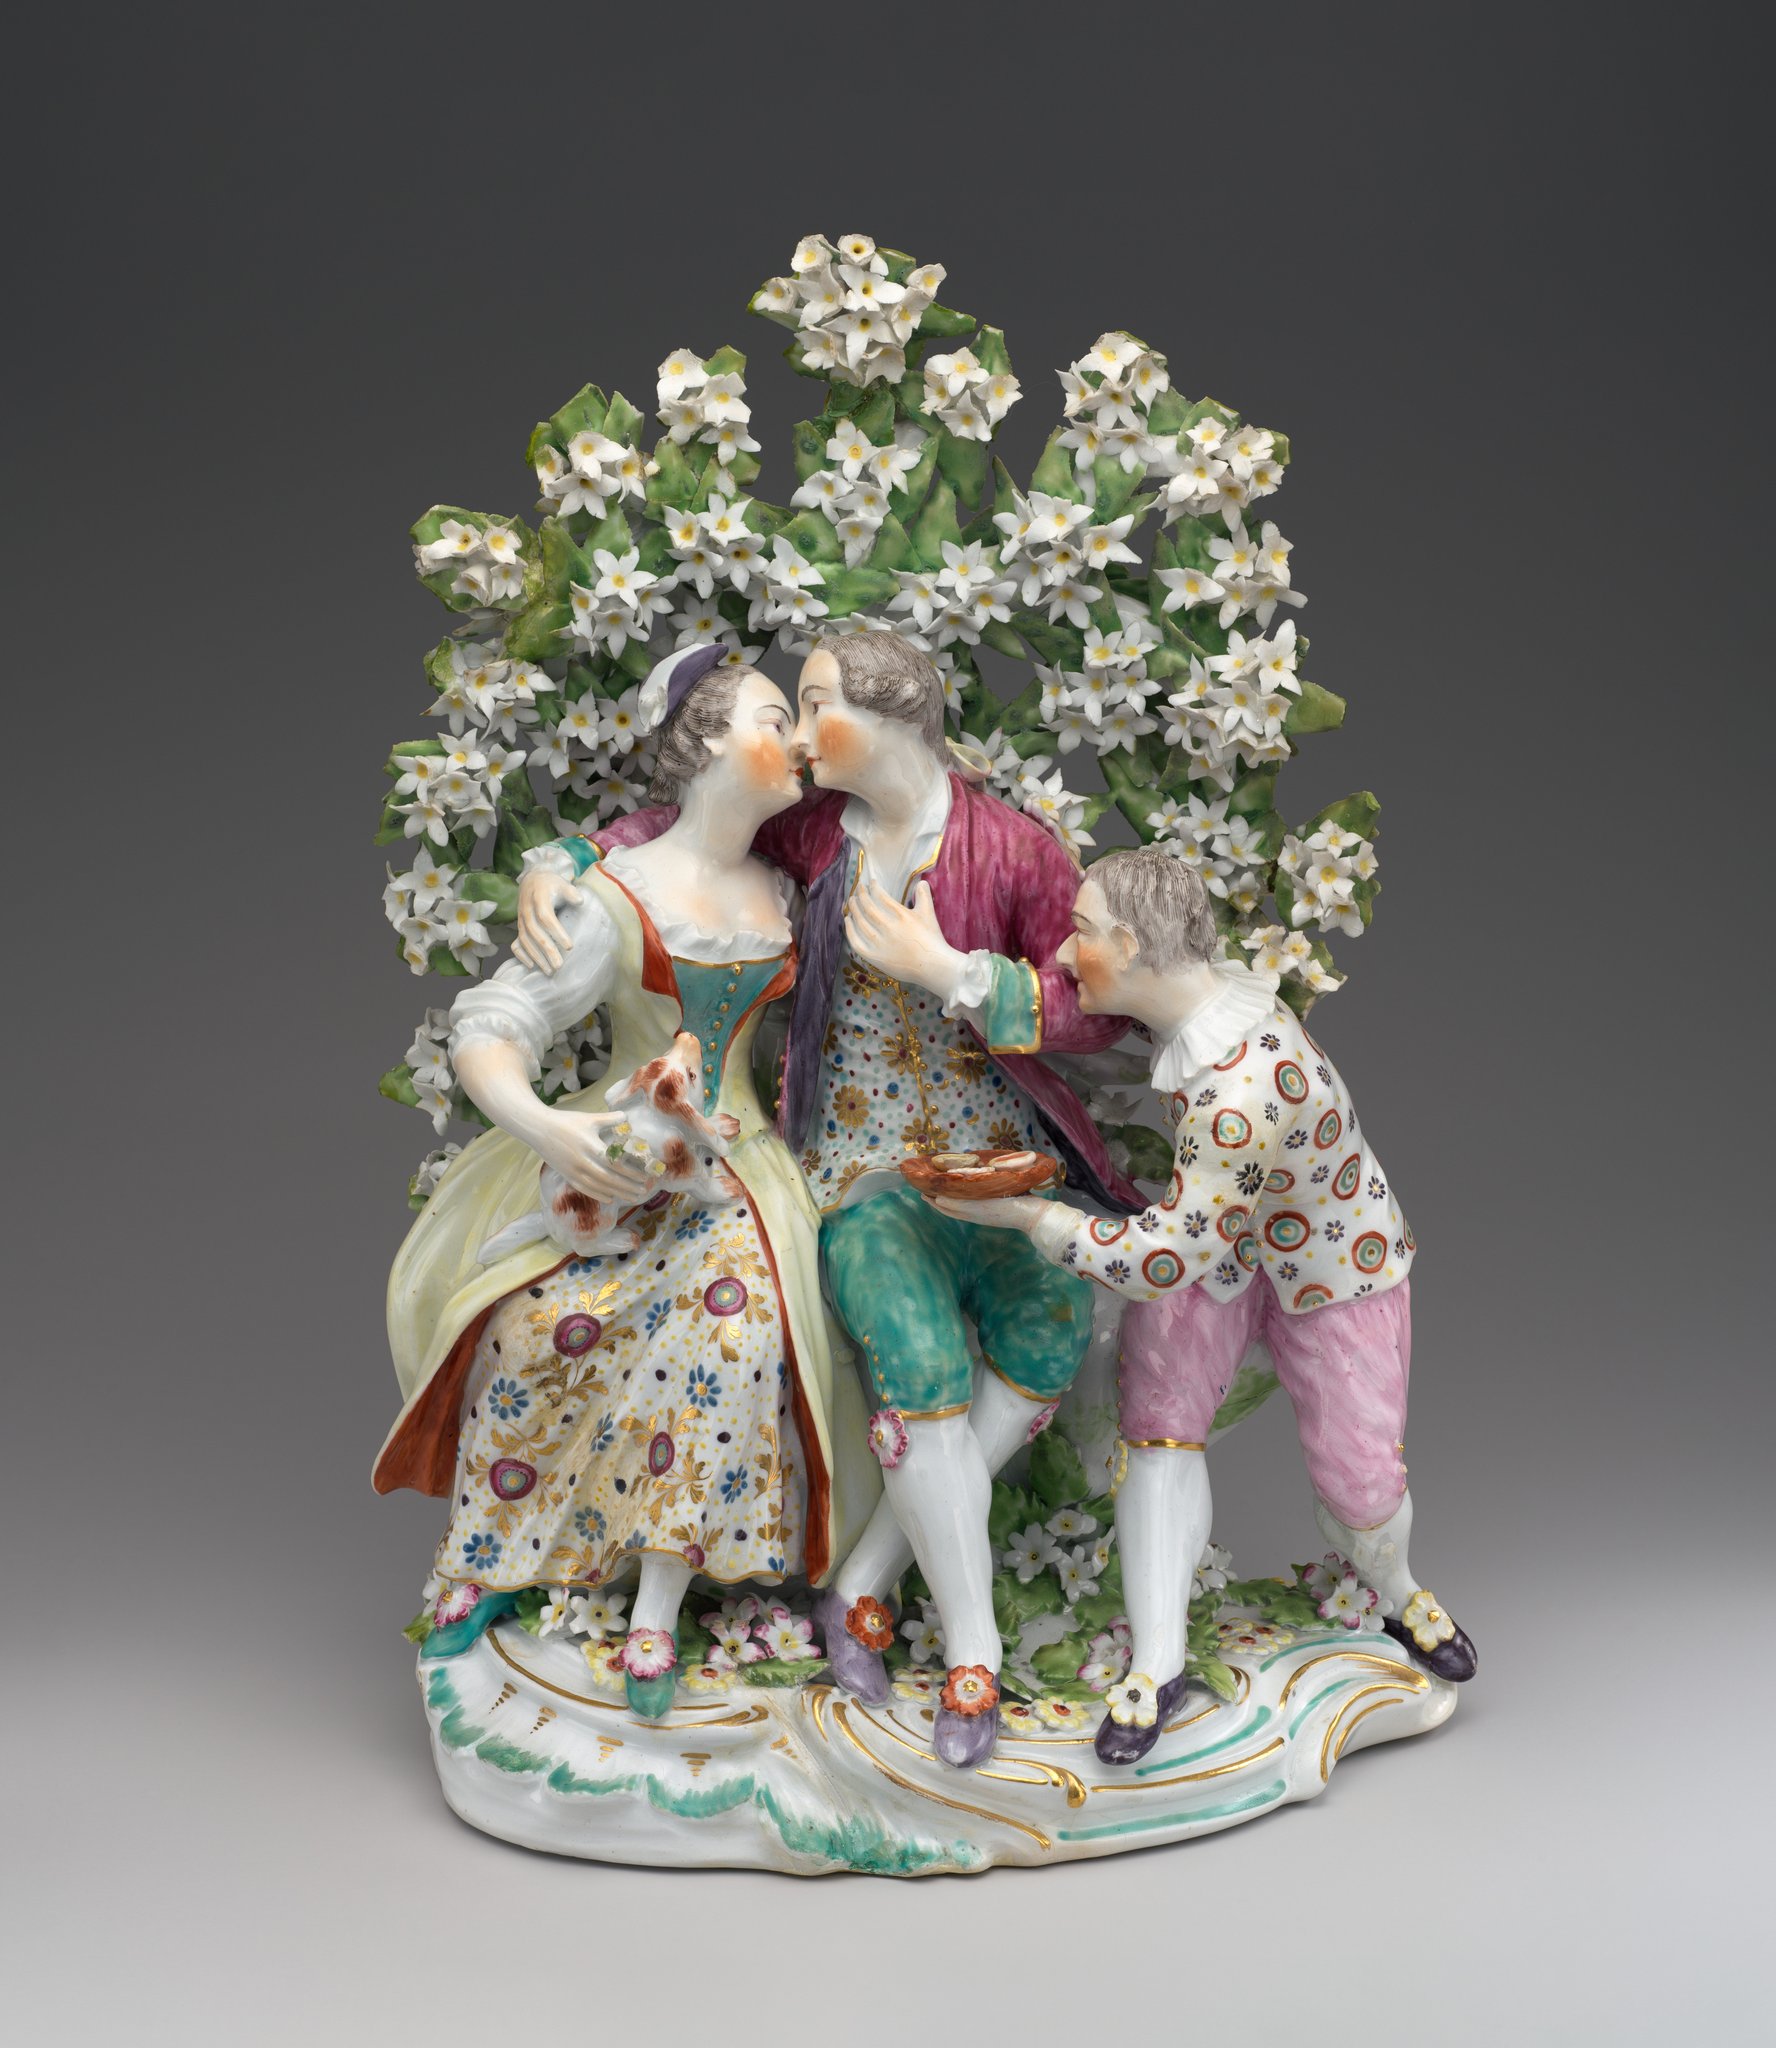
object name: group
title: Lovers and clown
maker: derby porcelain manufactory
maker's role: factory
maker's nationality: british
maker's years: 1751-1785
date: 1765-1770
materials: soft paste porcelain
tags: couples,men,women,clowns